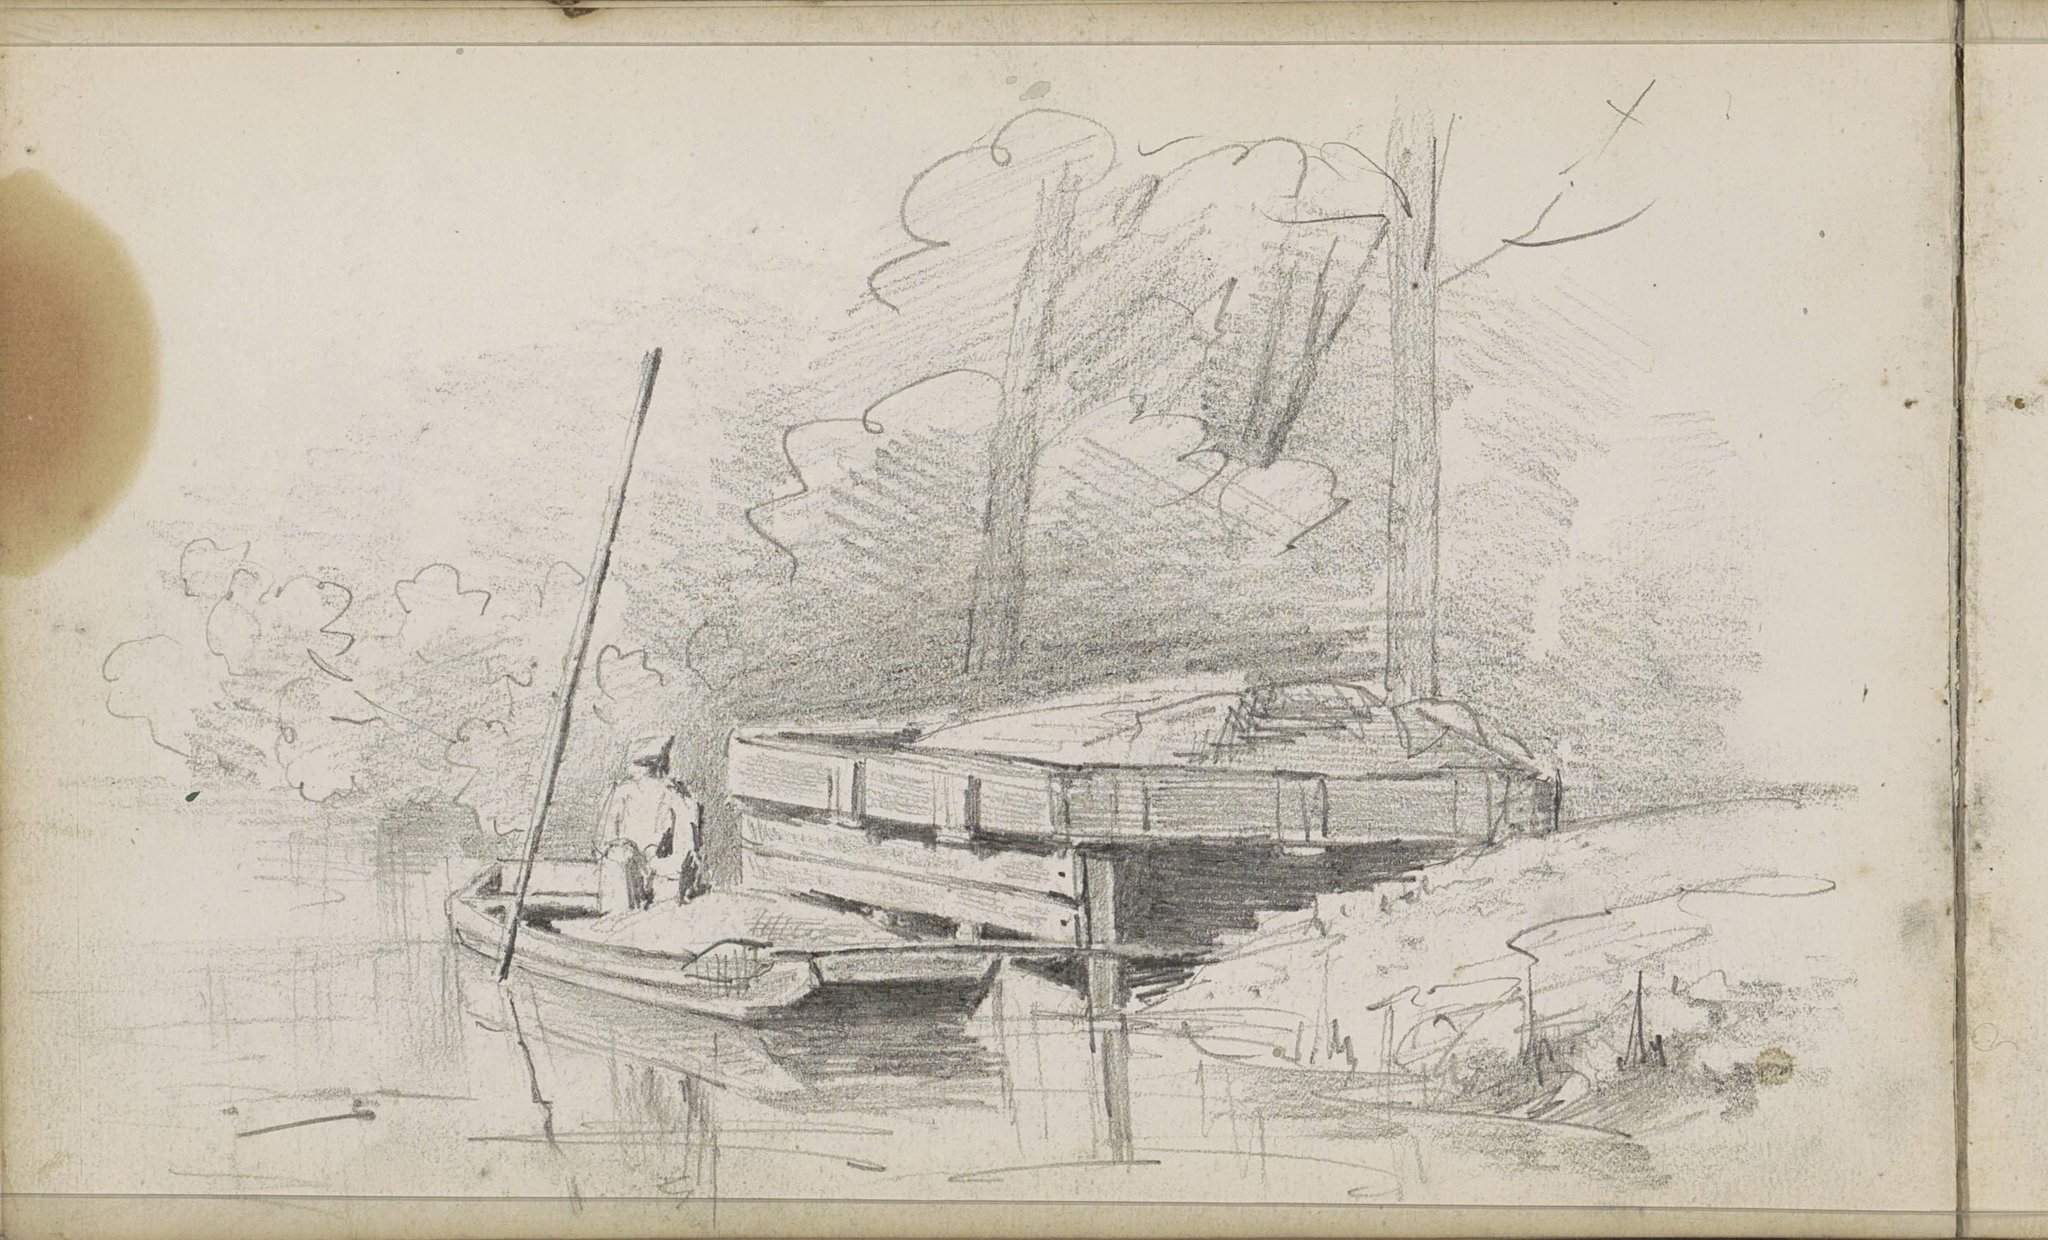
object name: sketchbook leaf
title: Man in een roeiboot bij een steiger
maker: willem cornelis rip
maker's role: draughtsman, painter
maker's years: 1856-1922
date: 1876-1877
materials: paper, pencil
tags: rowing-boat, canoe, etc., pier, quay, wharf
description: Blad 21 verso uit een schetsboek met 41 bladen.